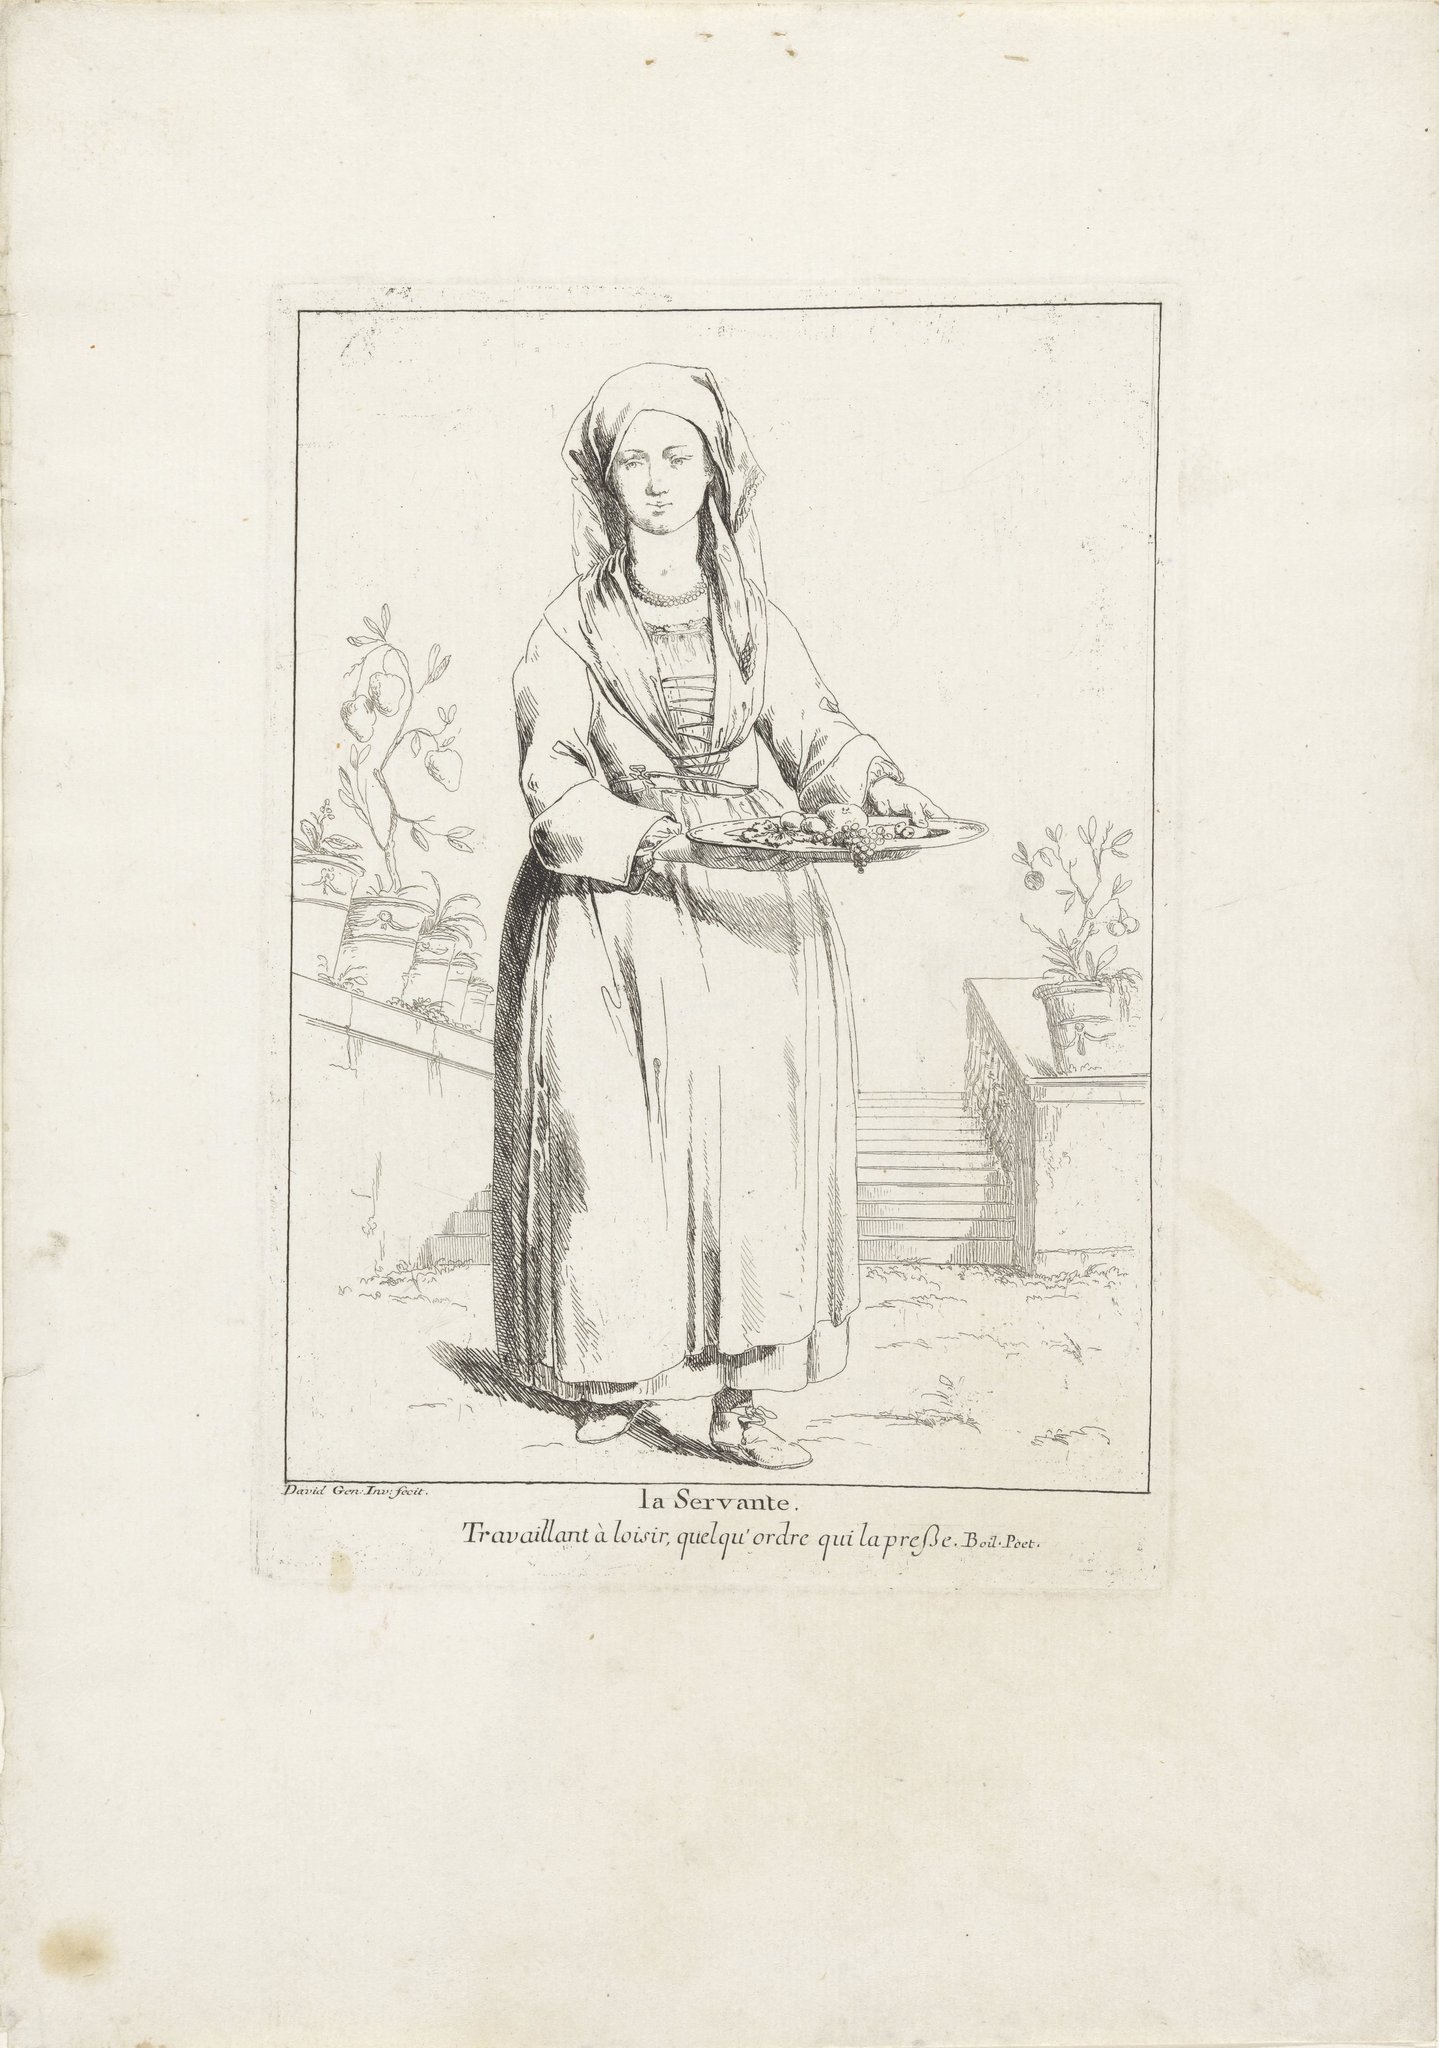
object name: print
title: Dienstmeid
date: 1775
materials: paper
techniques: etching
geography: venice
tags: maid ~ house personnel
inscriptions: collector's mark: Lugt 2228, collector's mark: Lugt 2760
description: Een dienstmeid met een dienblad met fruit. Op de achtergrond een trap en planten in potten.